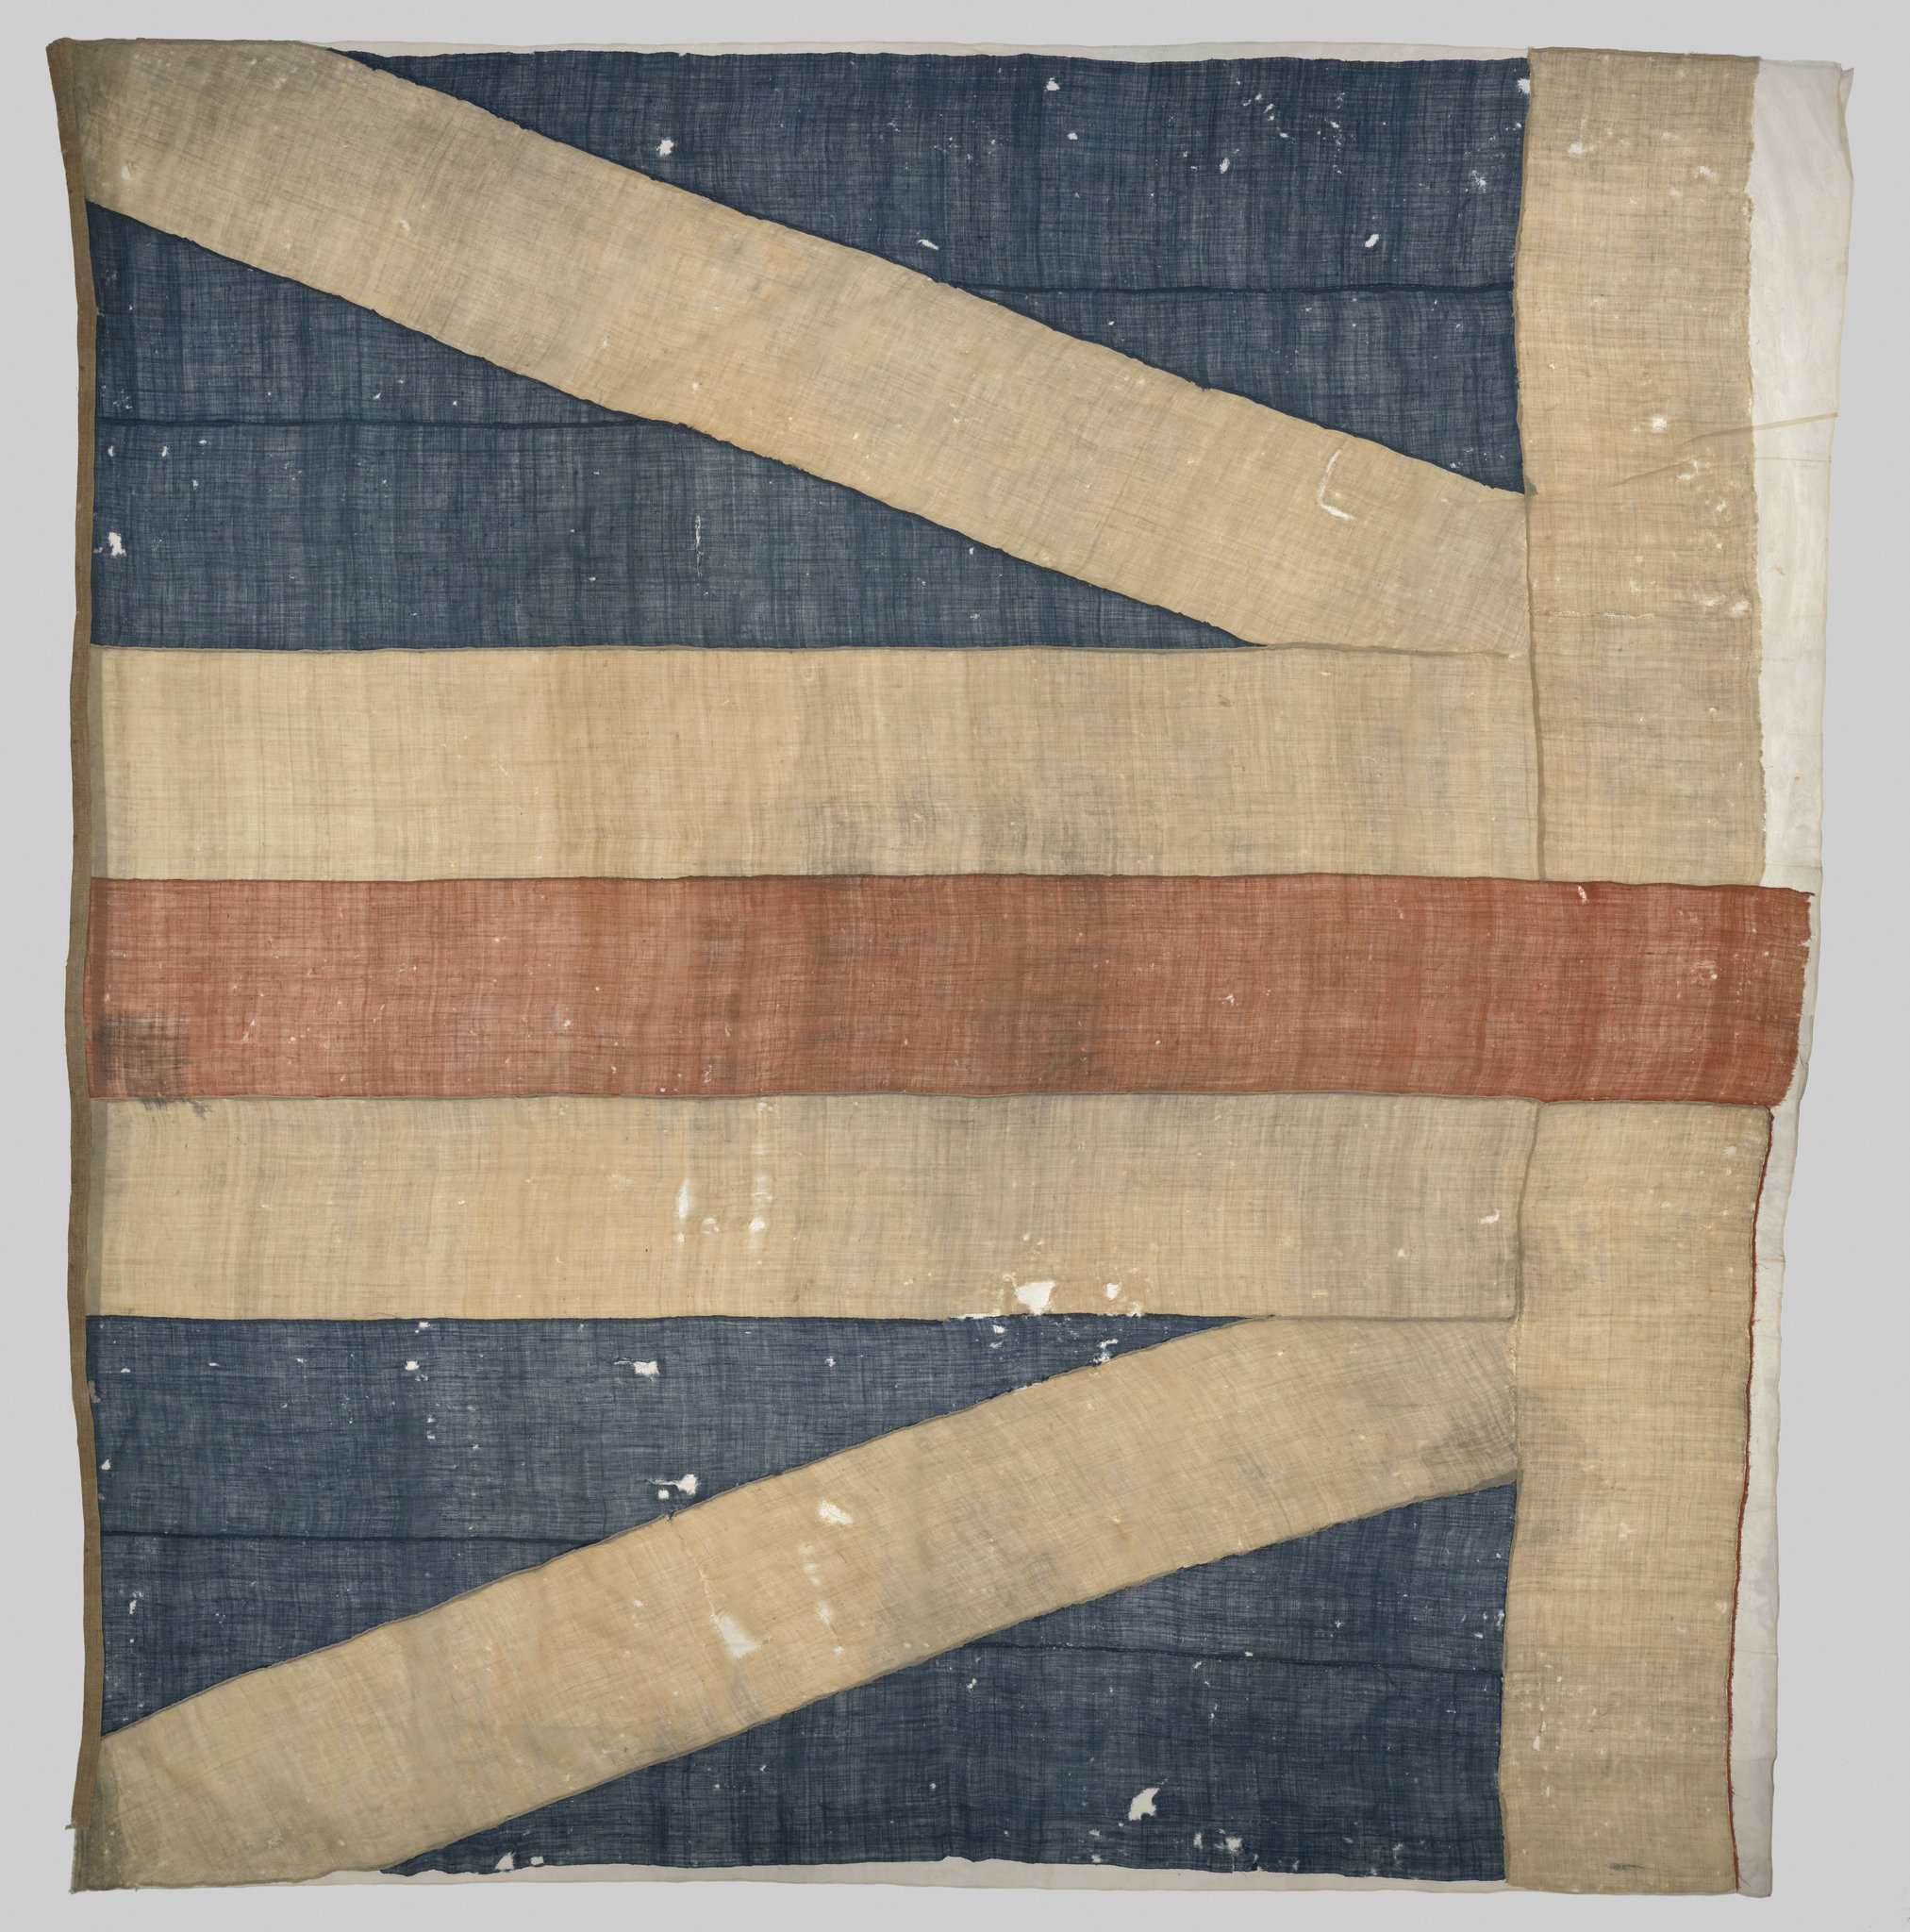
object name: ship flag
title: Fragment of a Ship Flag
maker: Anonymous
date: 1606-1700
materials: wool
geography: england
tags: flag, colours (as symbol of the state, etc.), england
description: Linkerhelft van een scheepsvlag, blauw met een rood in een wit kruis op een wit Andrieskruis. Dit is een Engelse Unievlag van de periode 1606-1700.